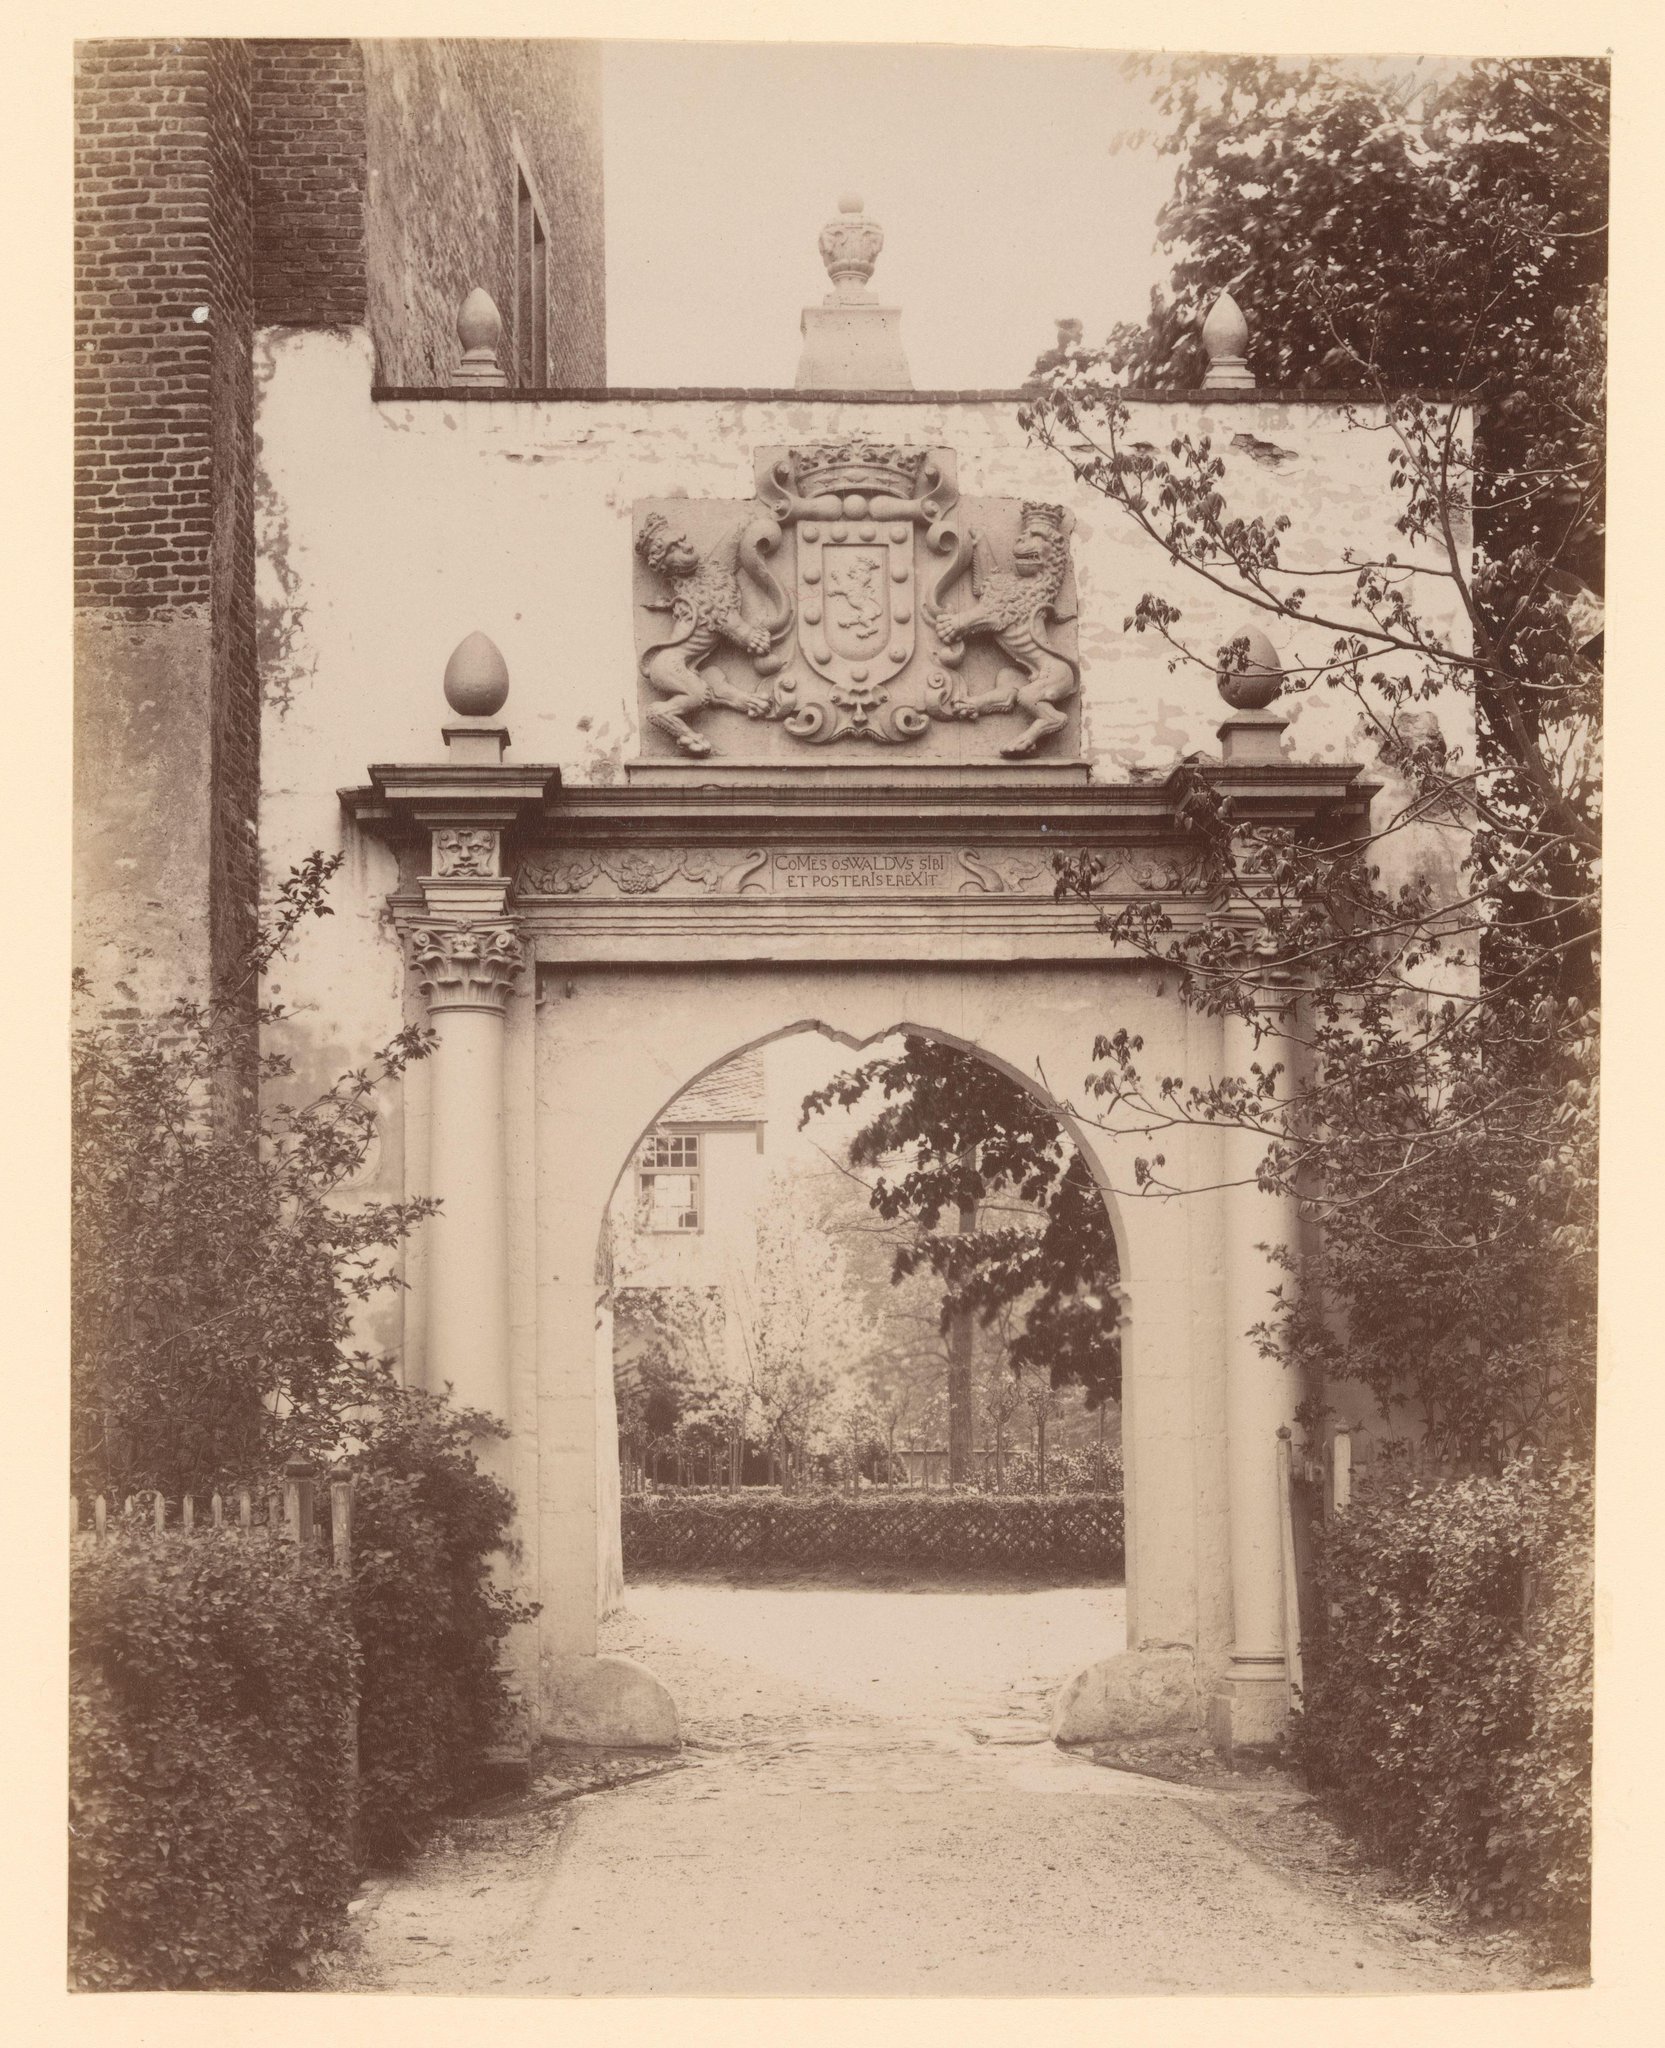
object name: photograph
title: Poort van het Huis Bergh te 's Heerenberg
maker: anoniem (monumentenzorg)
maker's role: fotograaf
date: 1890-1920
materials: cardboard, photographic support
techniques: albumen print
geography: s-heerenberg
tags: castle, gate, entrance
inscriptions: annotation: ‘M’, annotation: ‘Kasteel te 's Heerenberg’